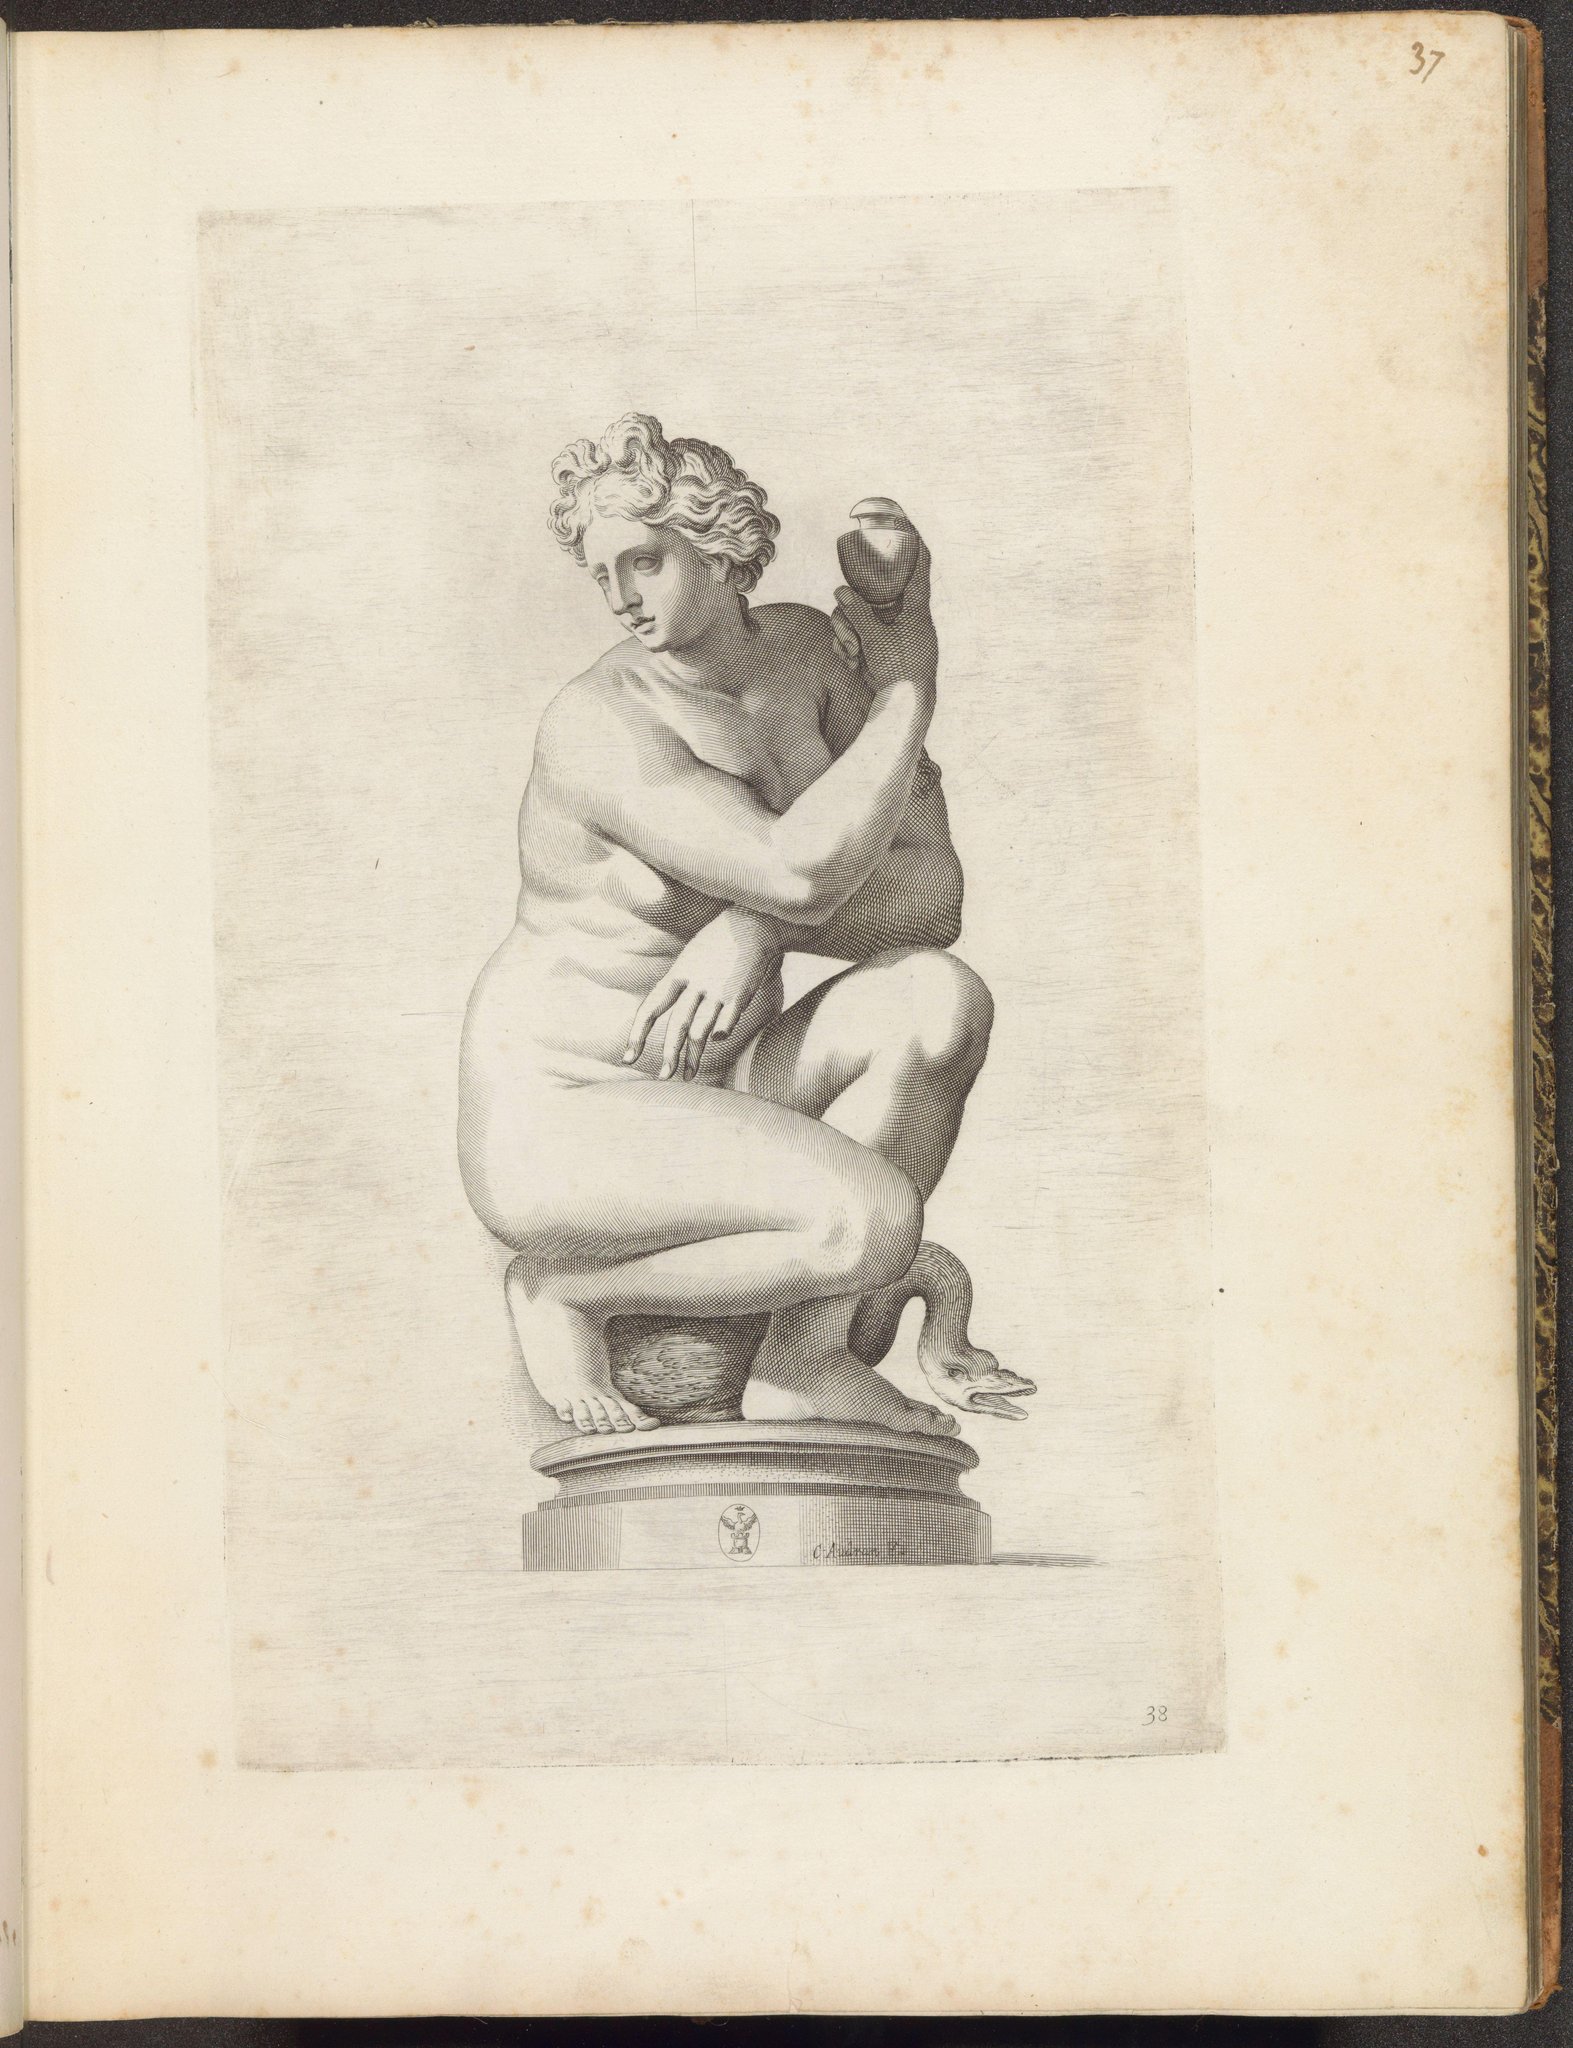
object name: album leaf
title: Galleria Giustiniana del Marchese Vincenzo Giustiniani I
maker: charles audran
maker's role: print maker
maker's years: 1594-1674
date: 1636-1647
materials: paper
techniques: engraving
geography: rome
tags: piece of sculpture, reproduction of a piece of sculpture, (story of) venus (aphrodite)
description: Standbeeld van Venus. Ze hurkt naast een zwaan. Op de basis het wapenschild van Vincenzo Giustiniani. Prent maakt deel uit van een album met een serie prenten naar de sculpturen in de verzameling in de Galleria Giustiniani te Rome.